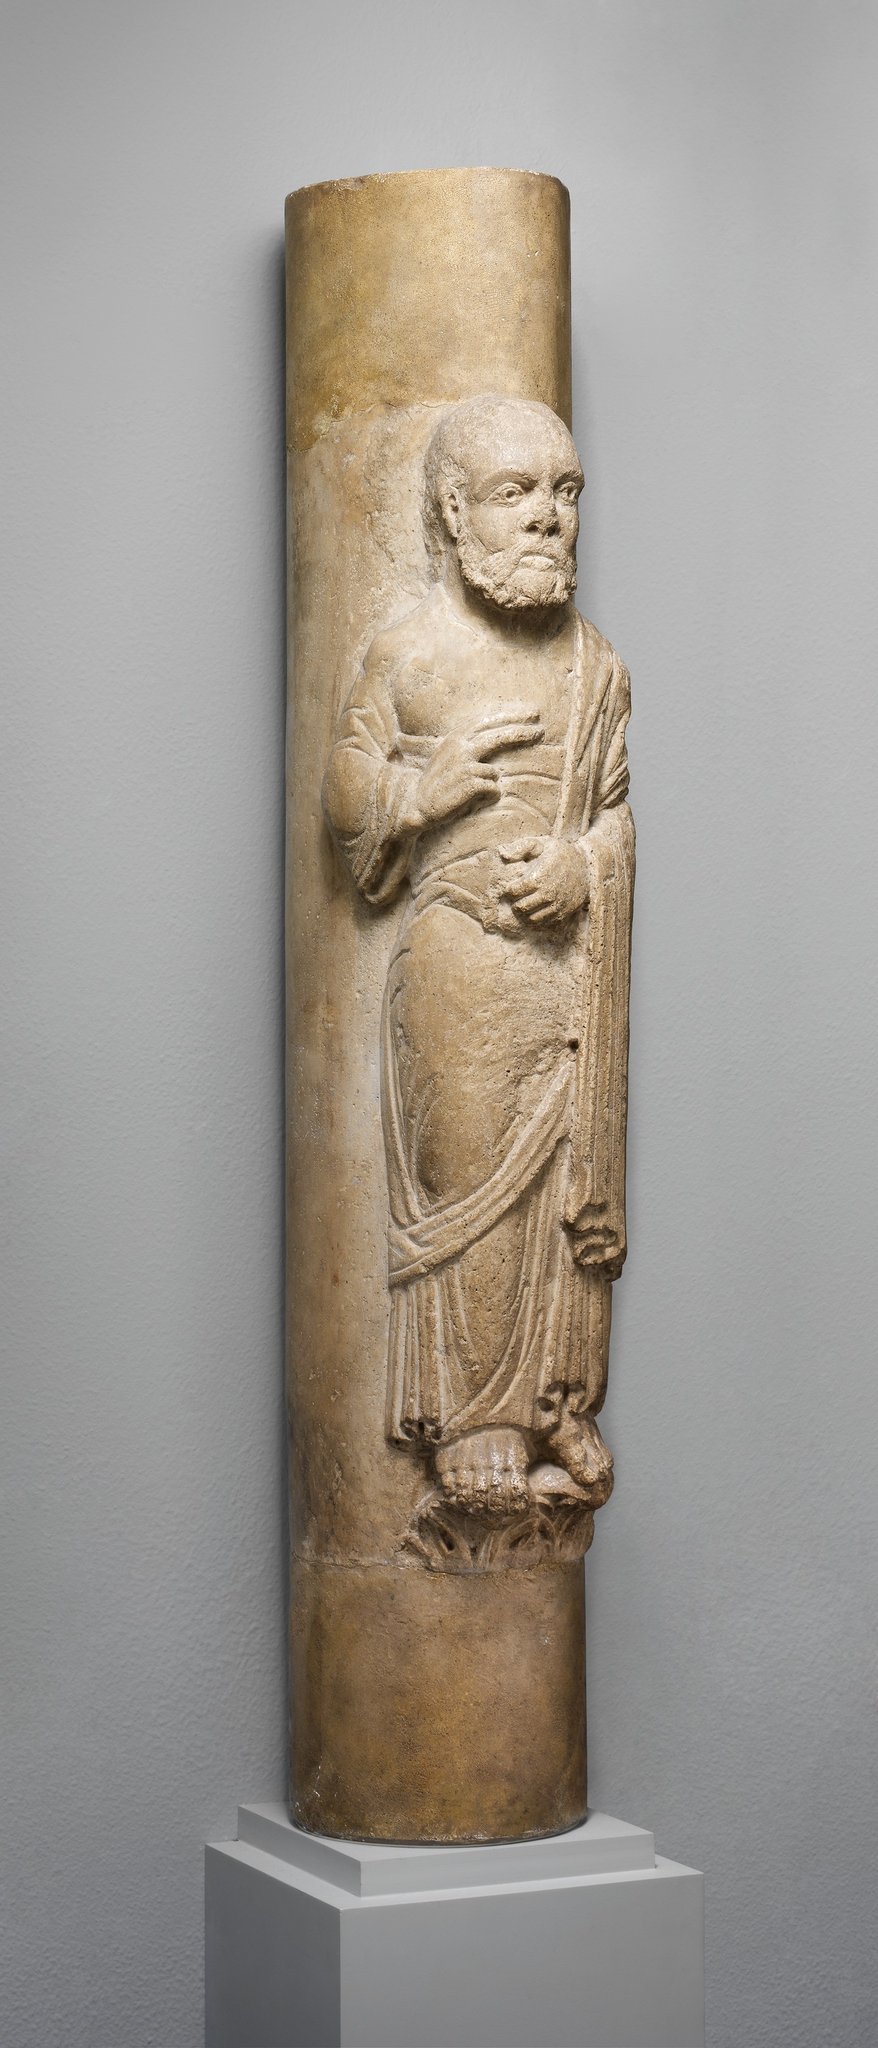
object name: column statue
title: Column Statue of an Apostle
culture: north italian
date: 1151-1200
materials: stone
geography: italy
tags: men,apostles